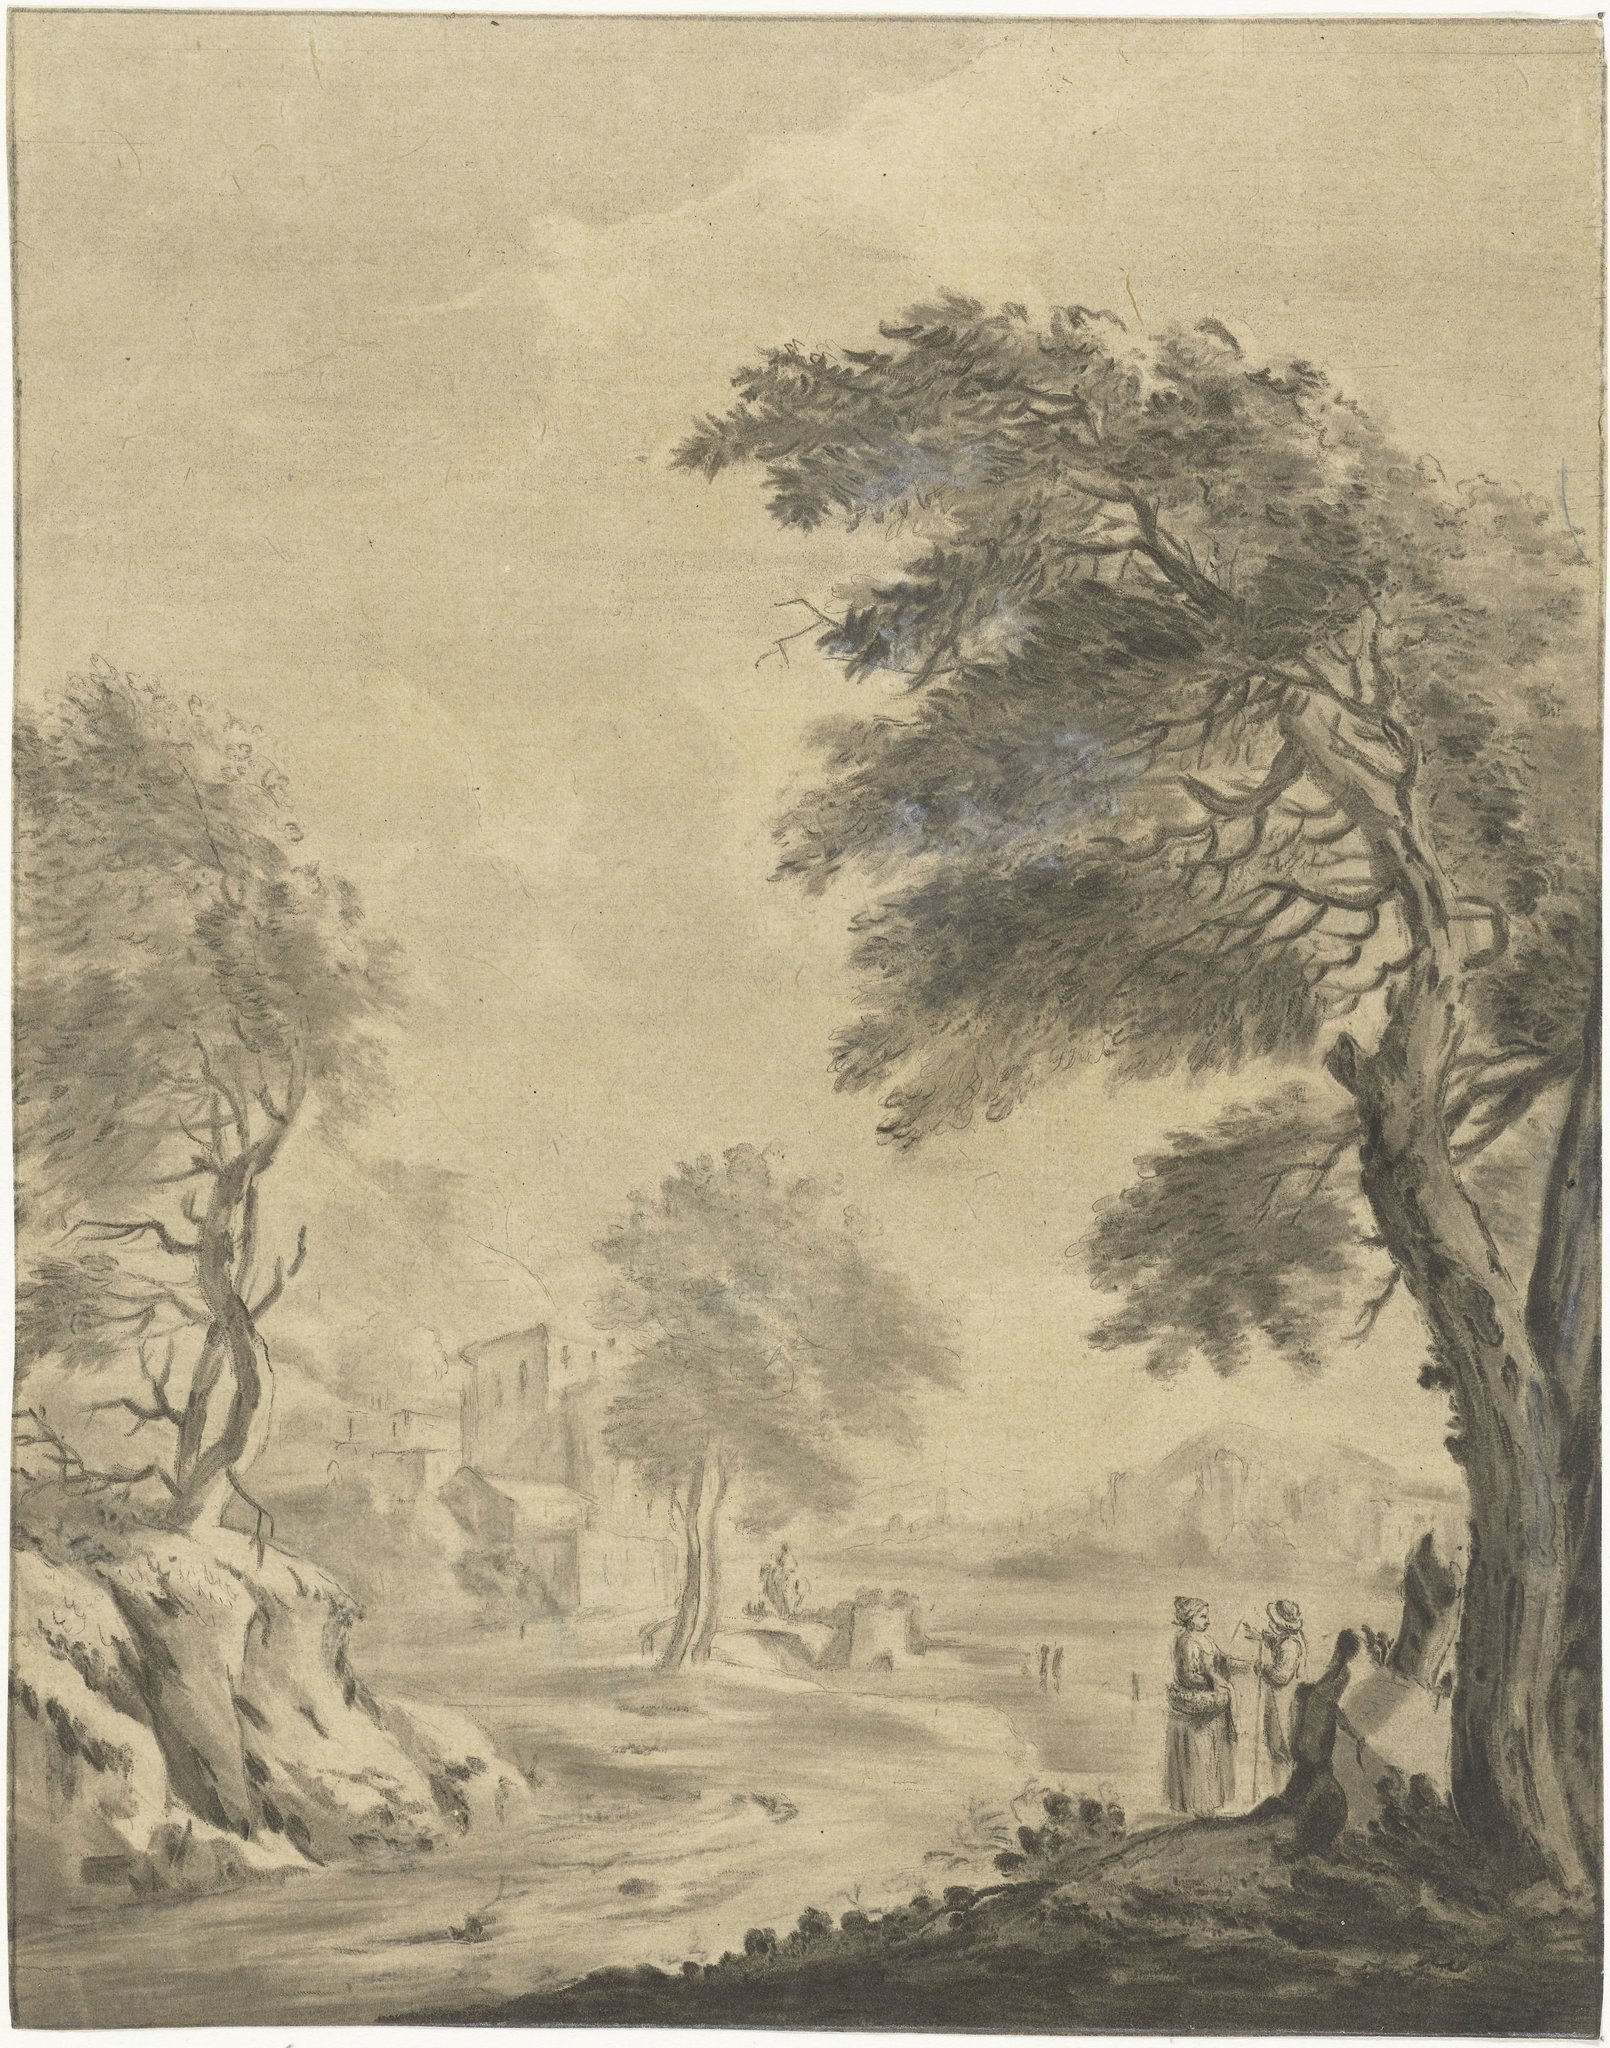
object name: print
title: Landschap met weg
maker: jurriaan cootwijck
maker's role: print maker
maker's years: 1714-1798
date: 1724-1798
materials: paper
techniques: print drawing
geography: amsterdam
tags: river, forest, wood (+ landscape with figures, staffage), outskirts of city - ii - ideal city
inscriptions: collector's mark: Lugt 2228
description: Landschap met op de voorgrond voetgangers aan de kant van een weg. In de achtergrond de contouren van een stad. De weg volgt een rivier richting de stad.